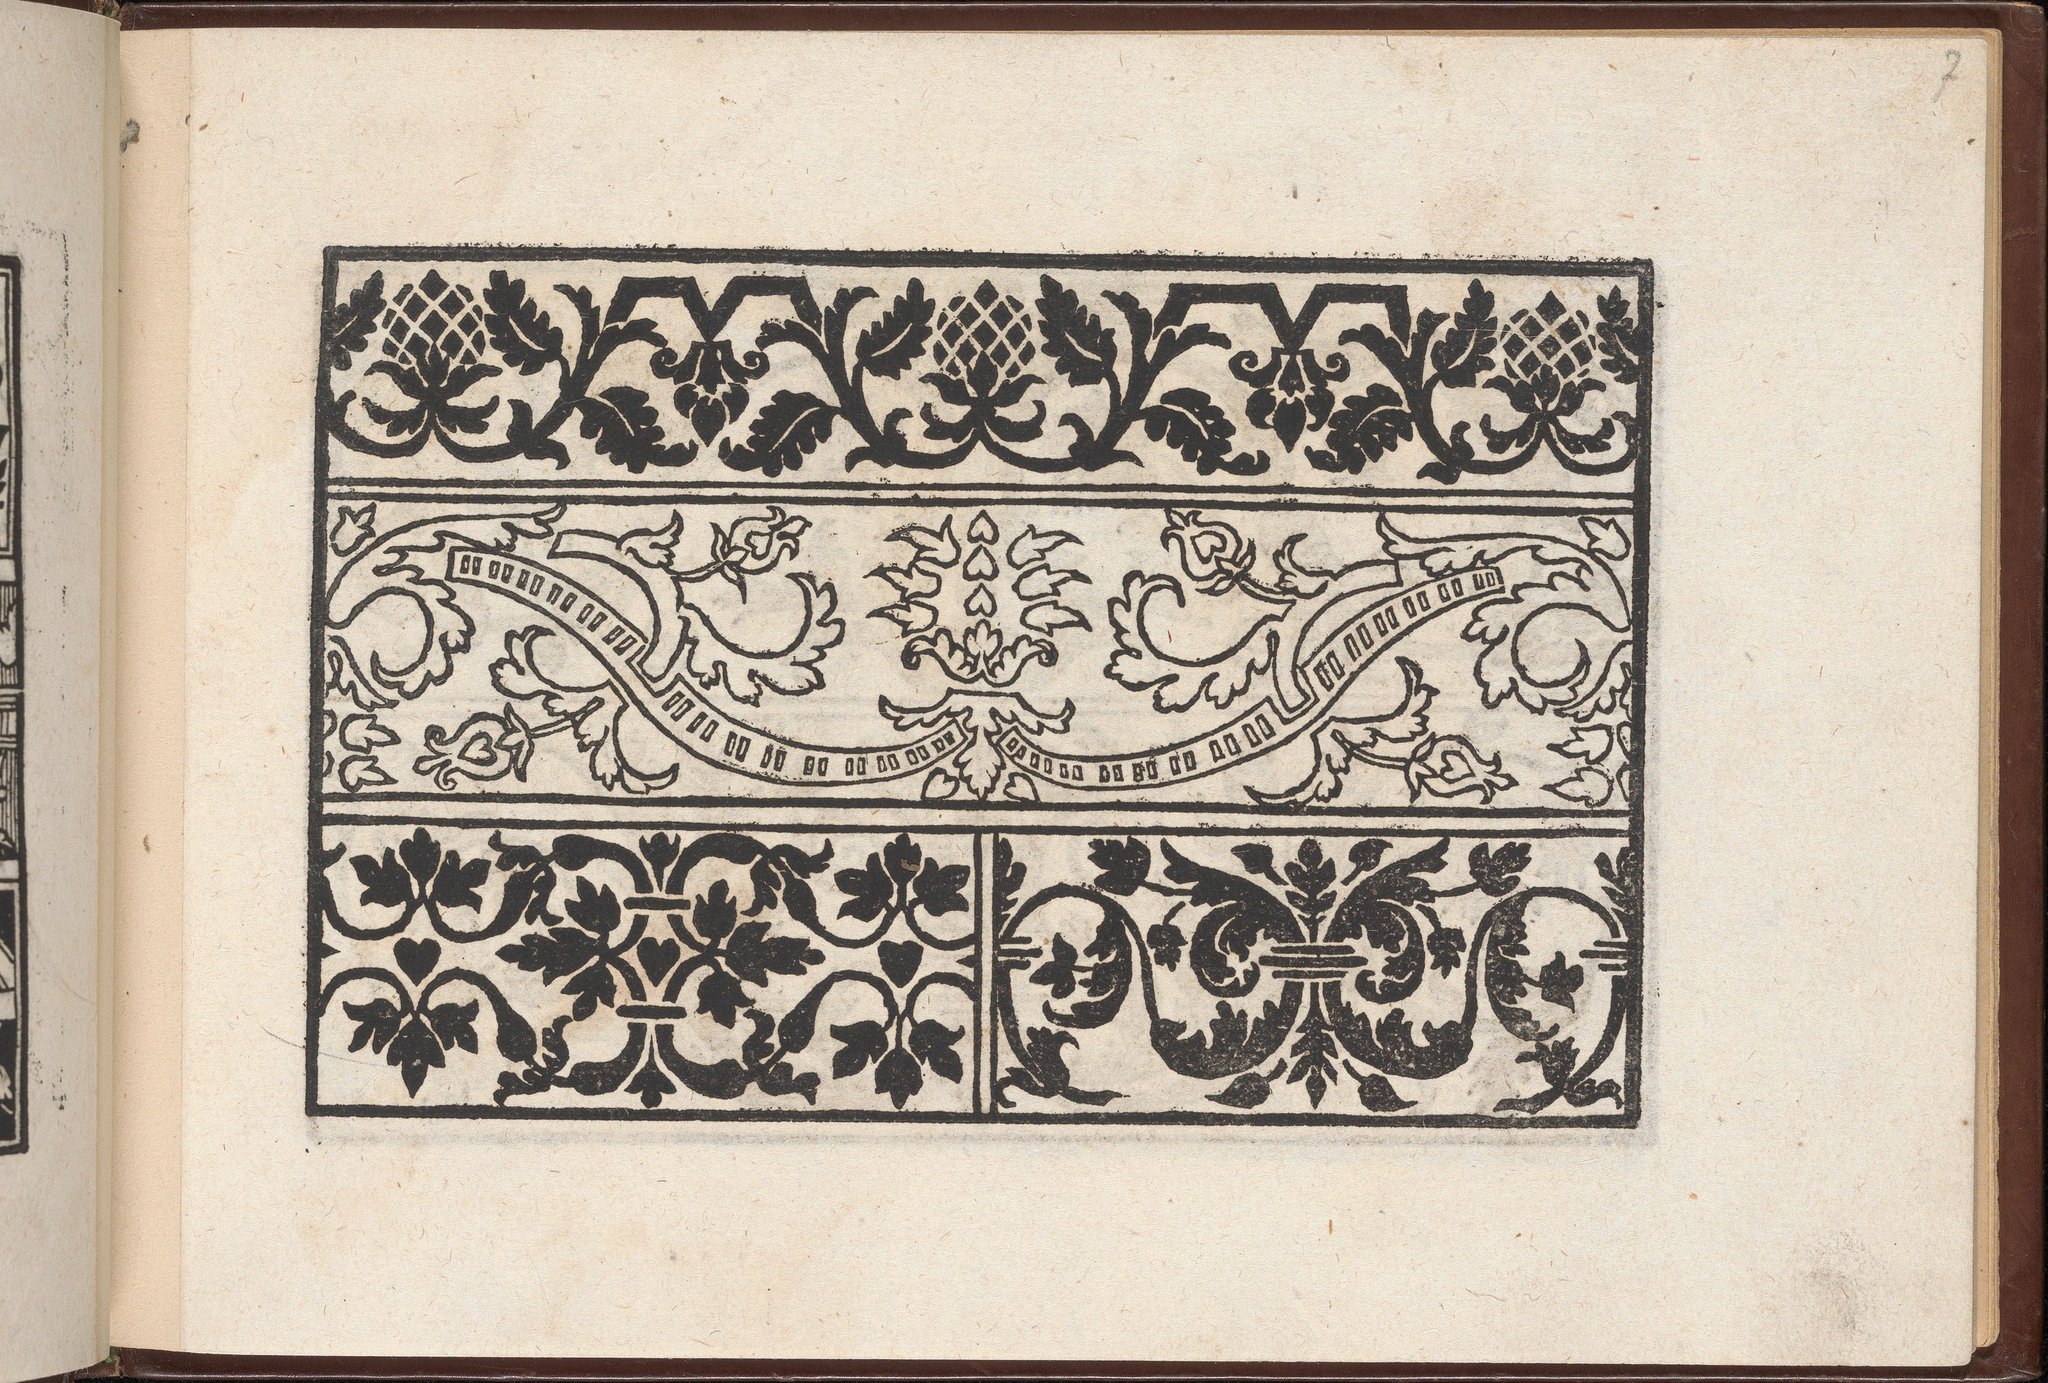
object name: book print ornament architecture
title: Page from Eyn Newe kunstlich moetdelboech alle kunst (Page 6v)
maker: peter quentel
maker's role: publisher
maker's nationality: german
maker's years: 1500-1550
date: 1532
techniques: woodcut